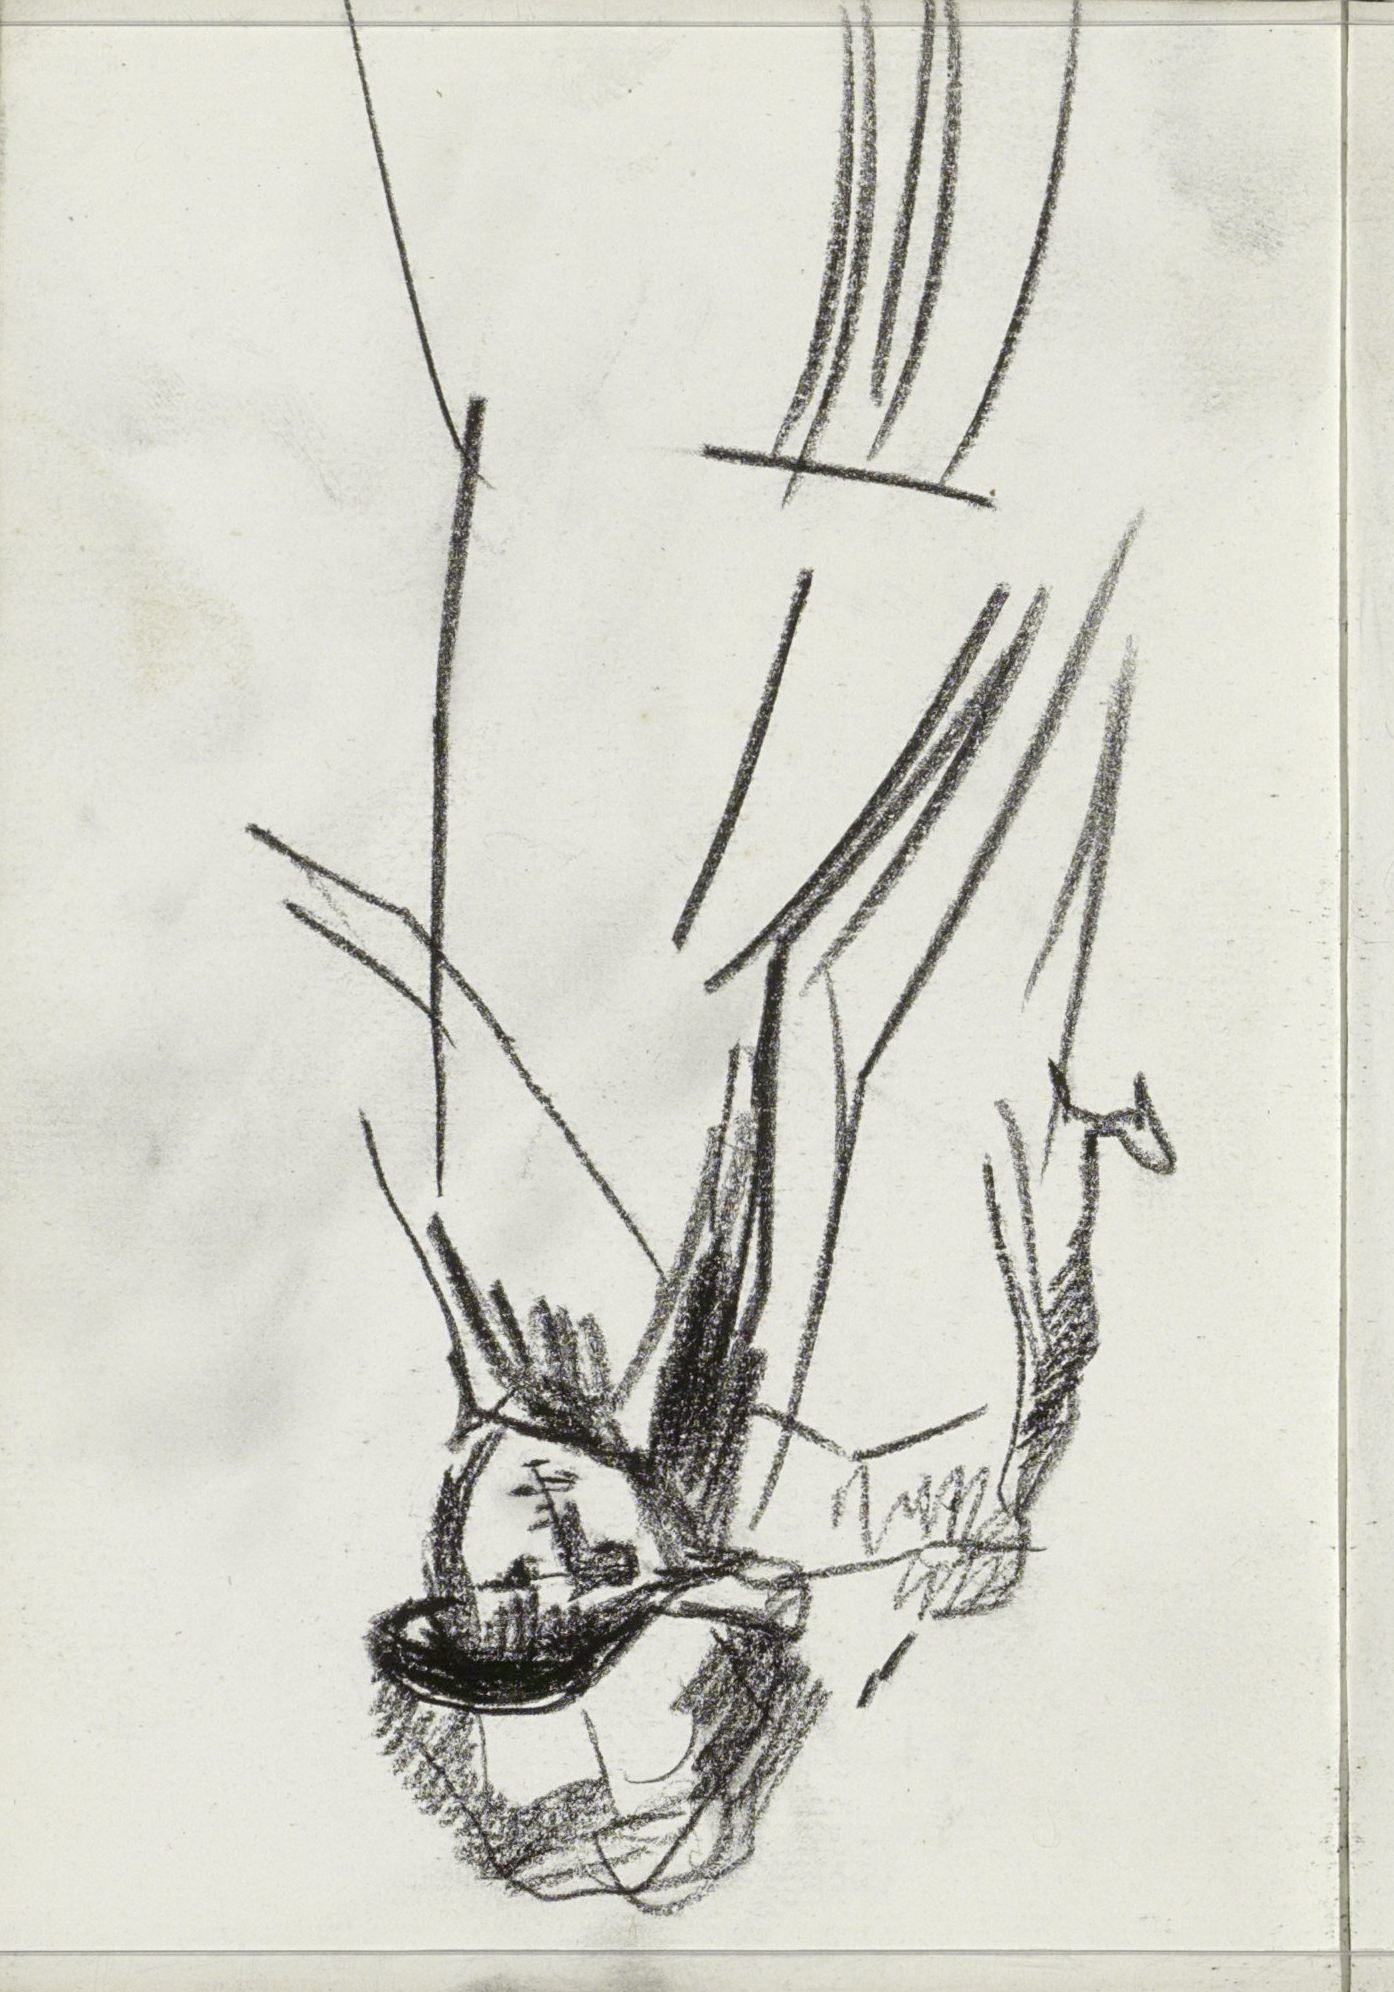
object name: sketchbook leaf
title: Jonge vrouw, over haar schouder kijkend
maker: isaac israels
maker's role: draughtsman, painter, print maker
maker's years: 1865-1934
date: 1886-1903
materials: chalk, paper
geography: amsterdam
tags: adolescent, young woman, maiden (+ standing), looking over the shoulder - aa - female human figure (+ sideview, profile)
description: Pagina 36 uit schetsboek XXXVII met 52 pagina's.